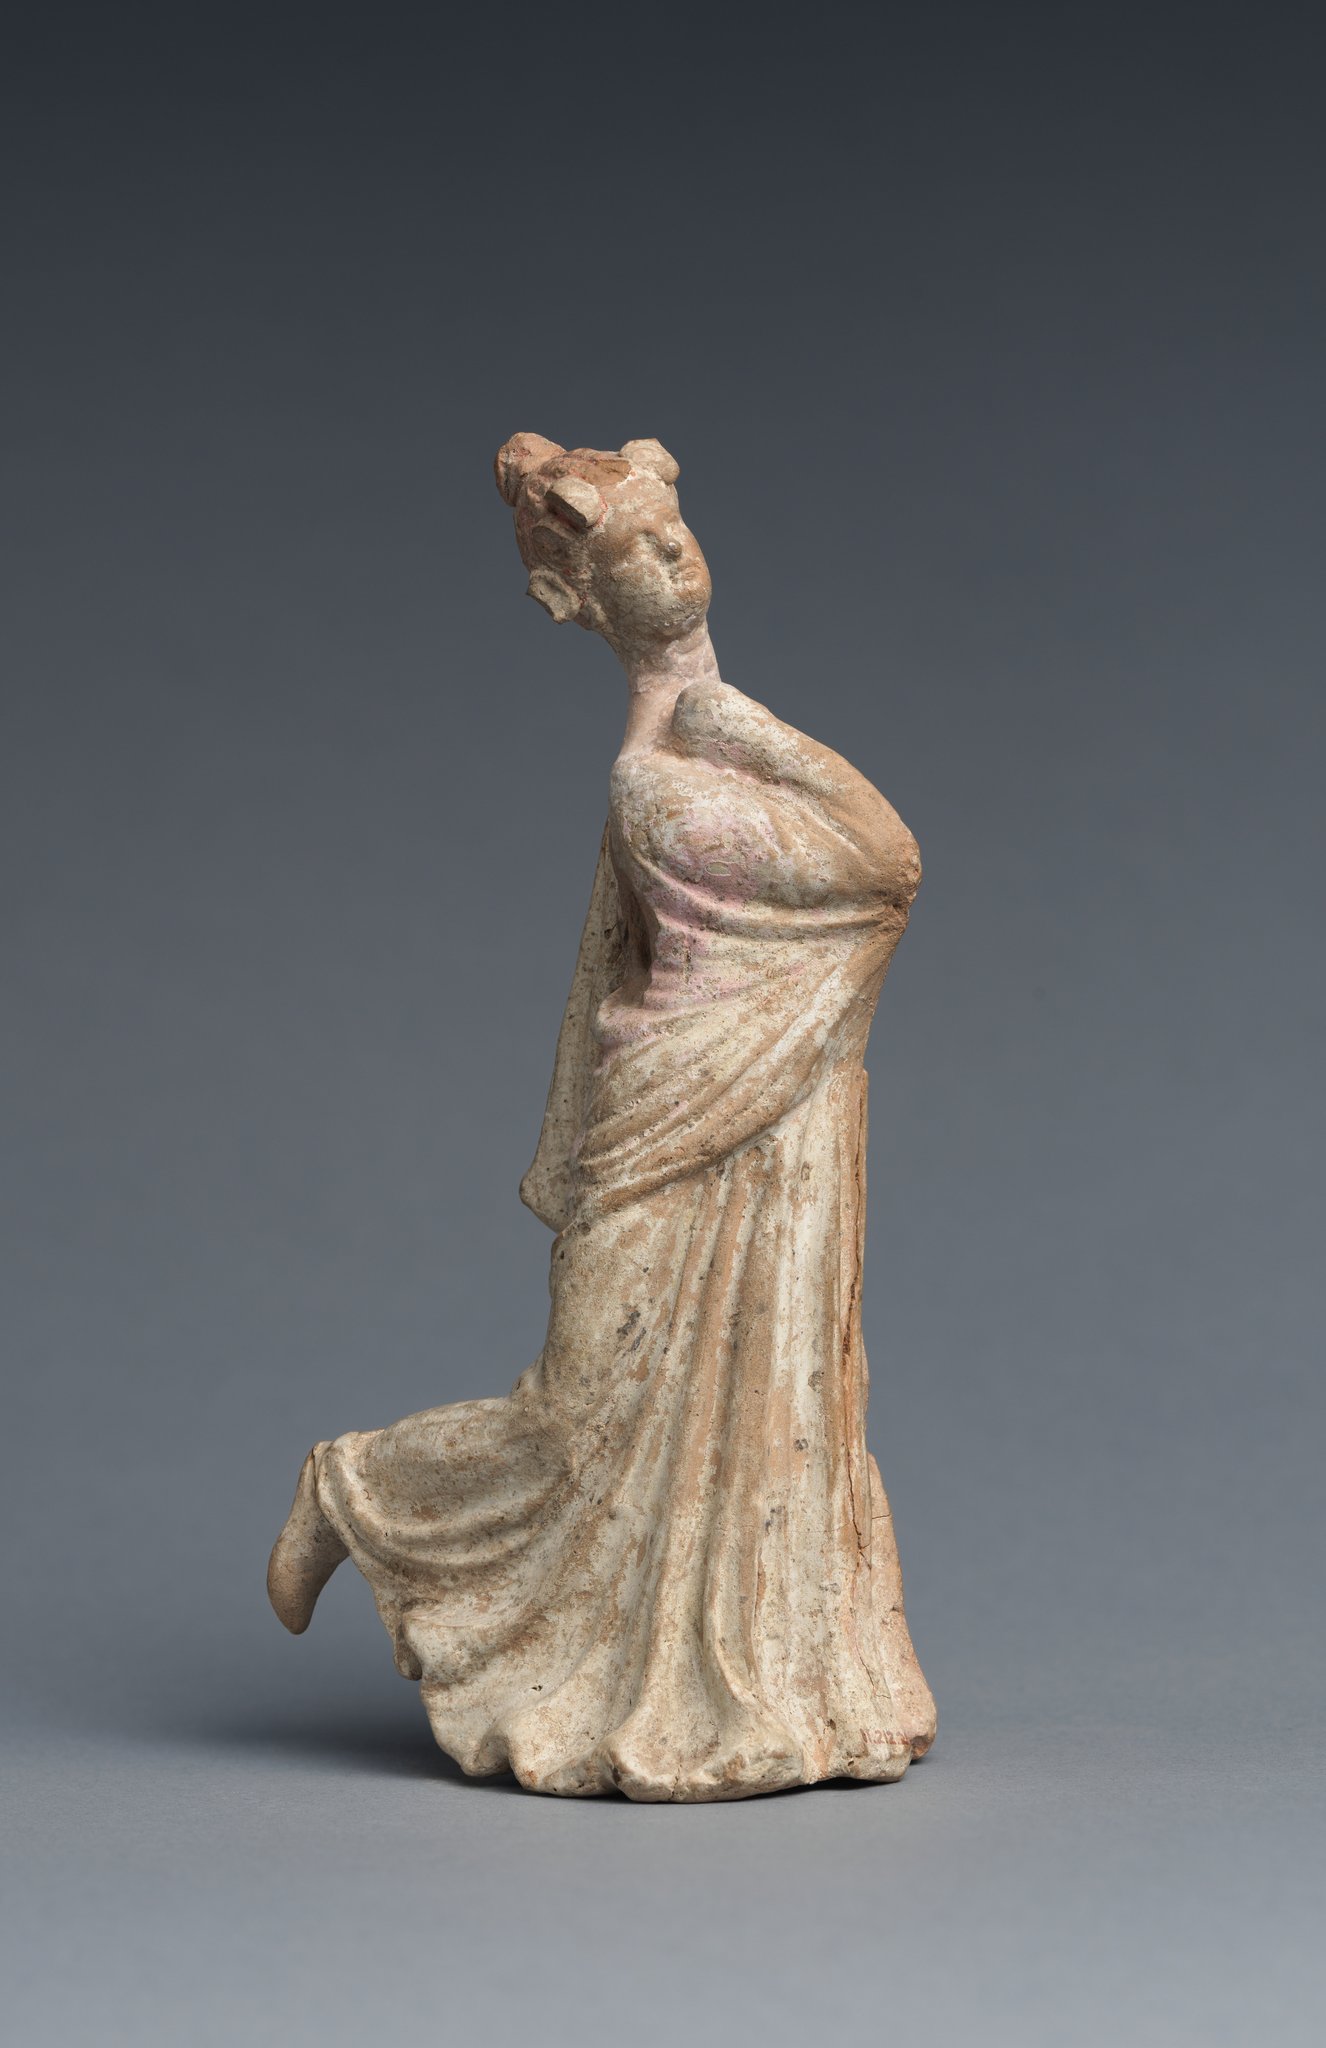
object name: statuette of a girl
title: Terracotta statuette of a dancing woman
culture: greek, south italian, tarentine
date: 300-201 BCE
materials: terracotta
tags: women,dancers